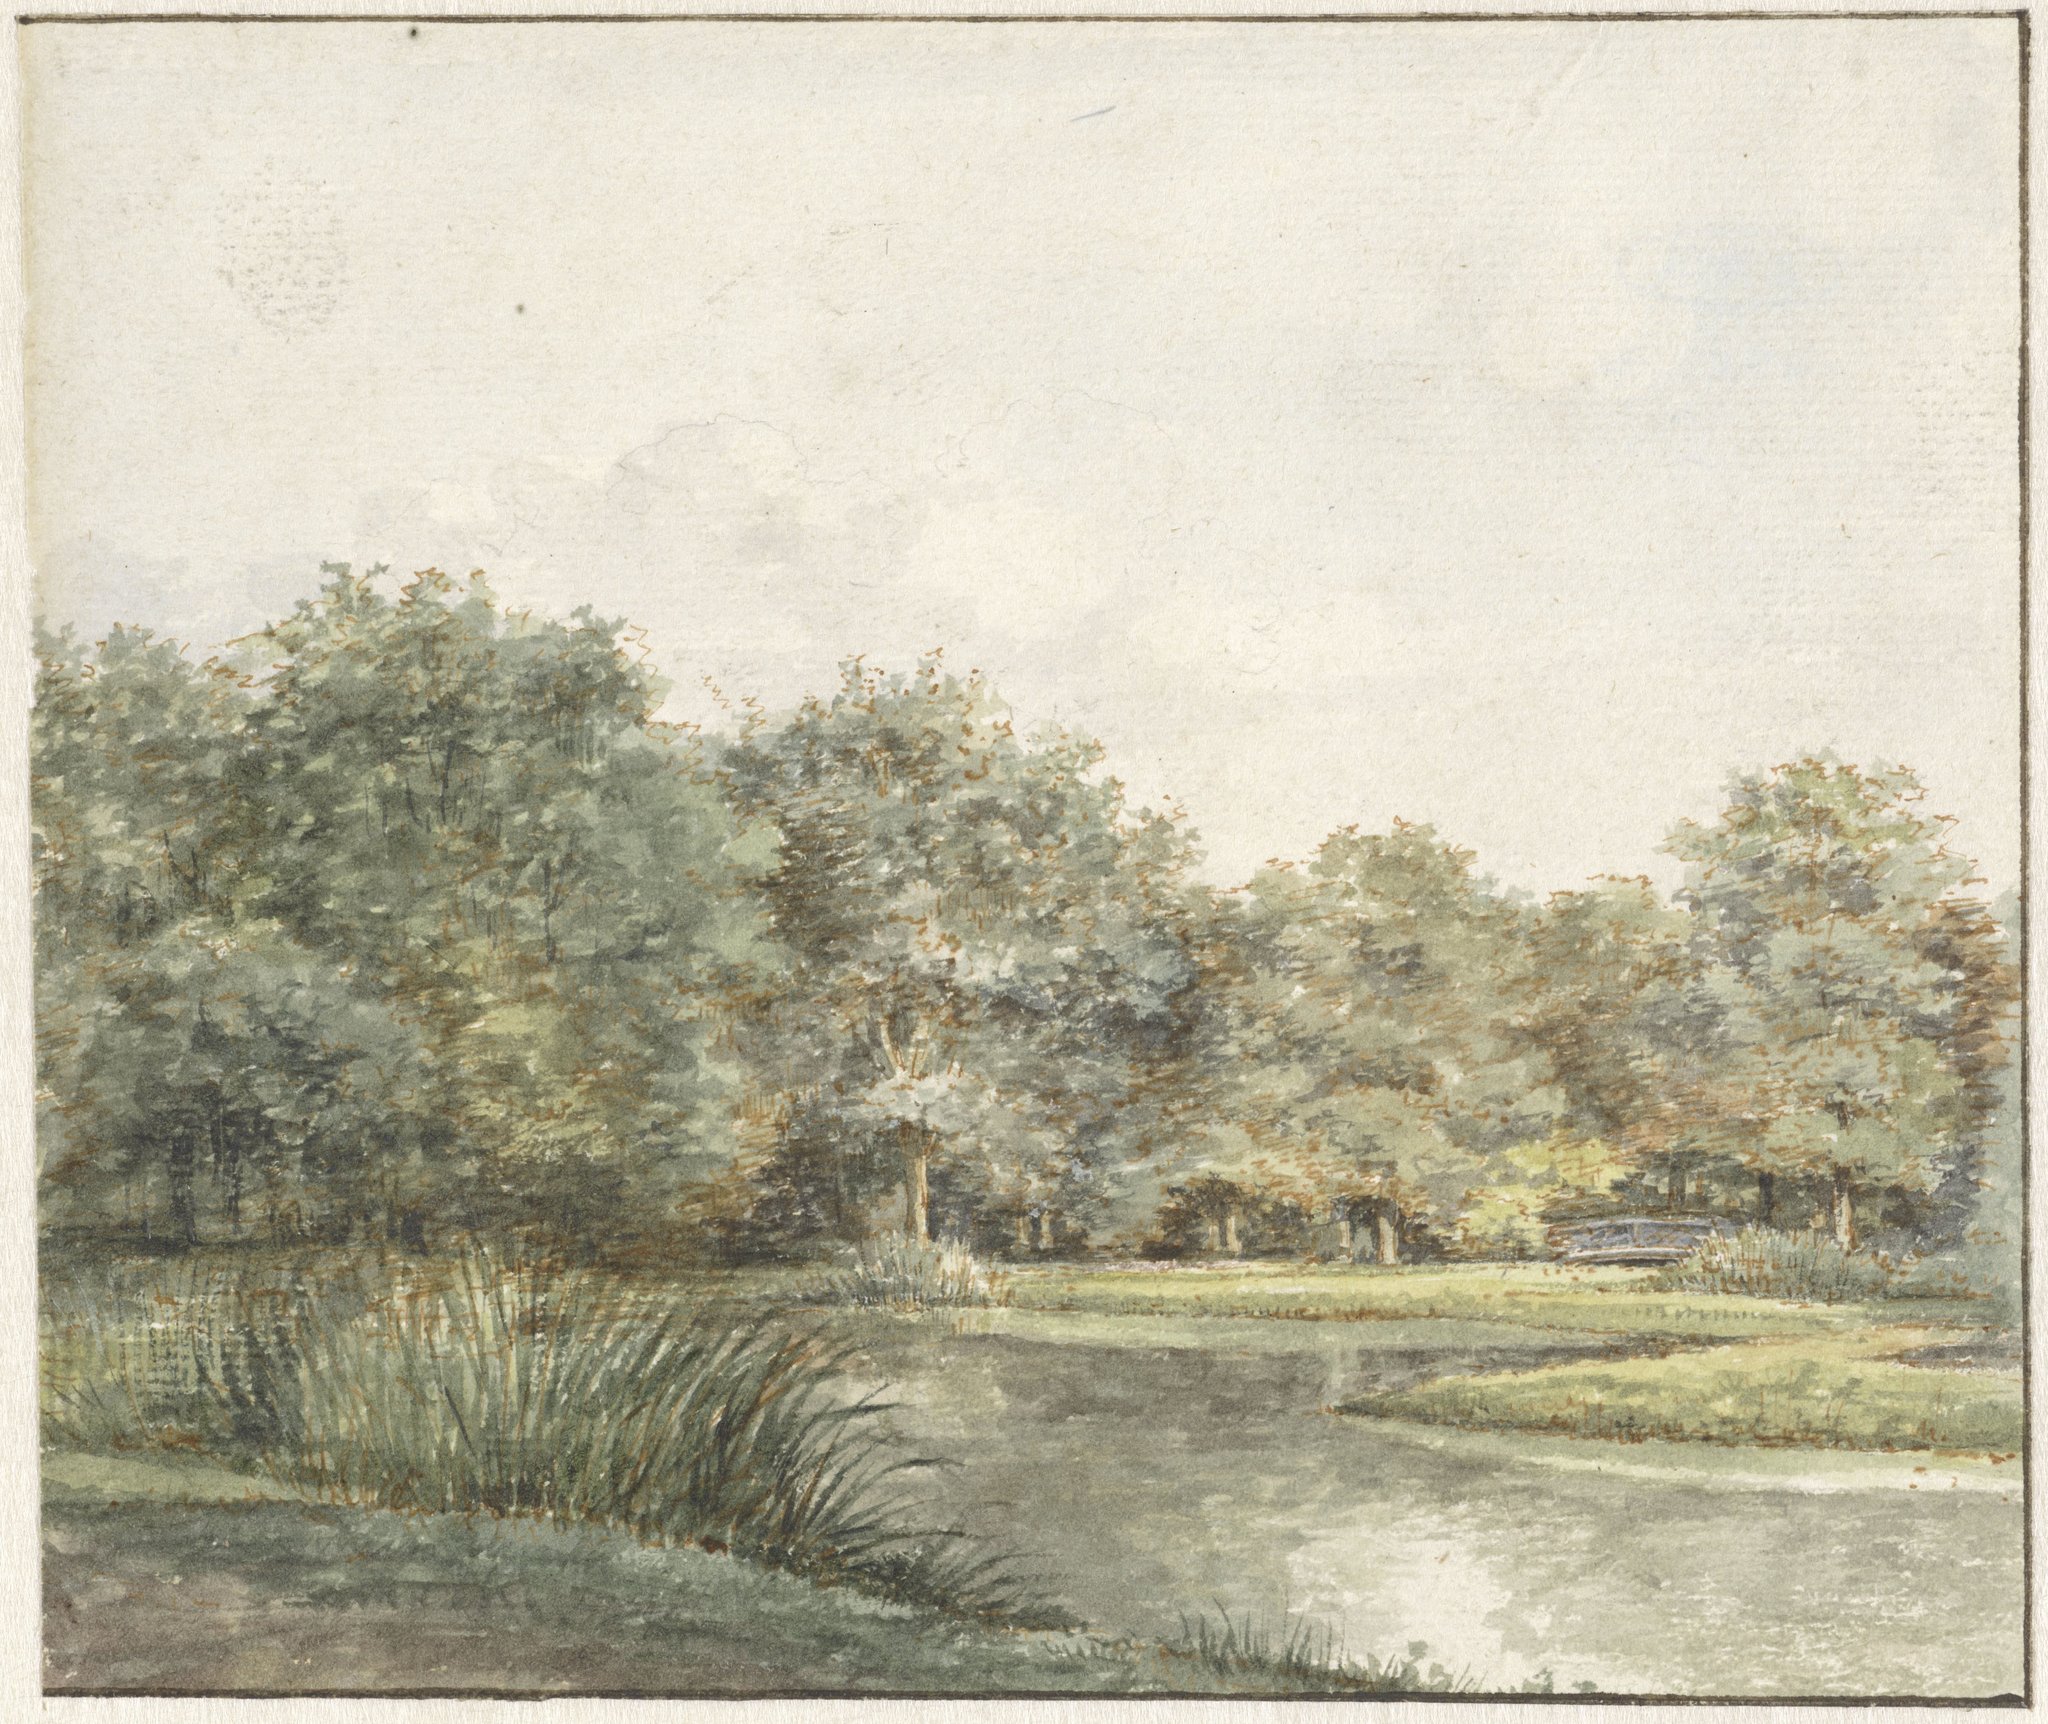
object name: drawing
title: Landschap met bomen aan het water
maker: pieter ernst hendrik praetorius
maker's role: draughtsman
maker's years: 1791-1876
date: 1821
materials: ink, paper, pencil, watercolor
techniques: brush, pen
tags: public gardens, park